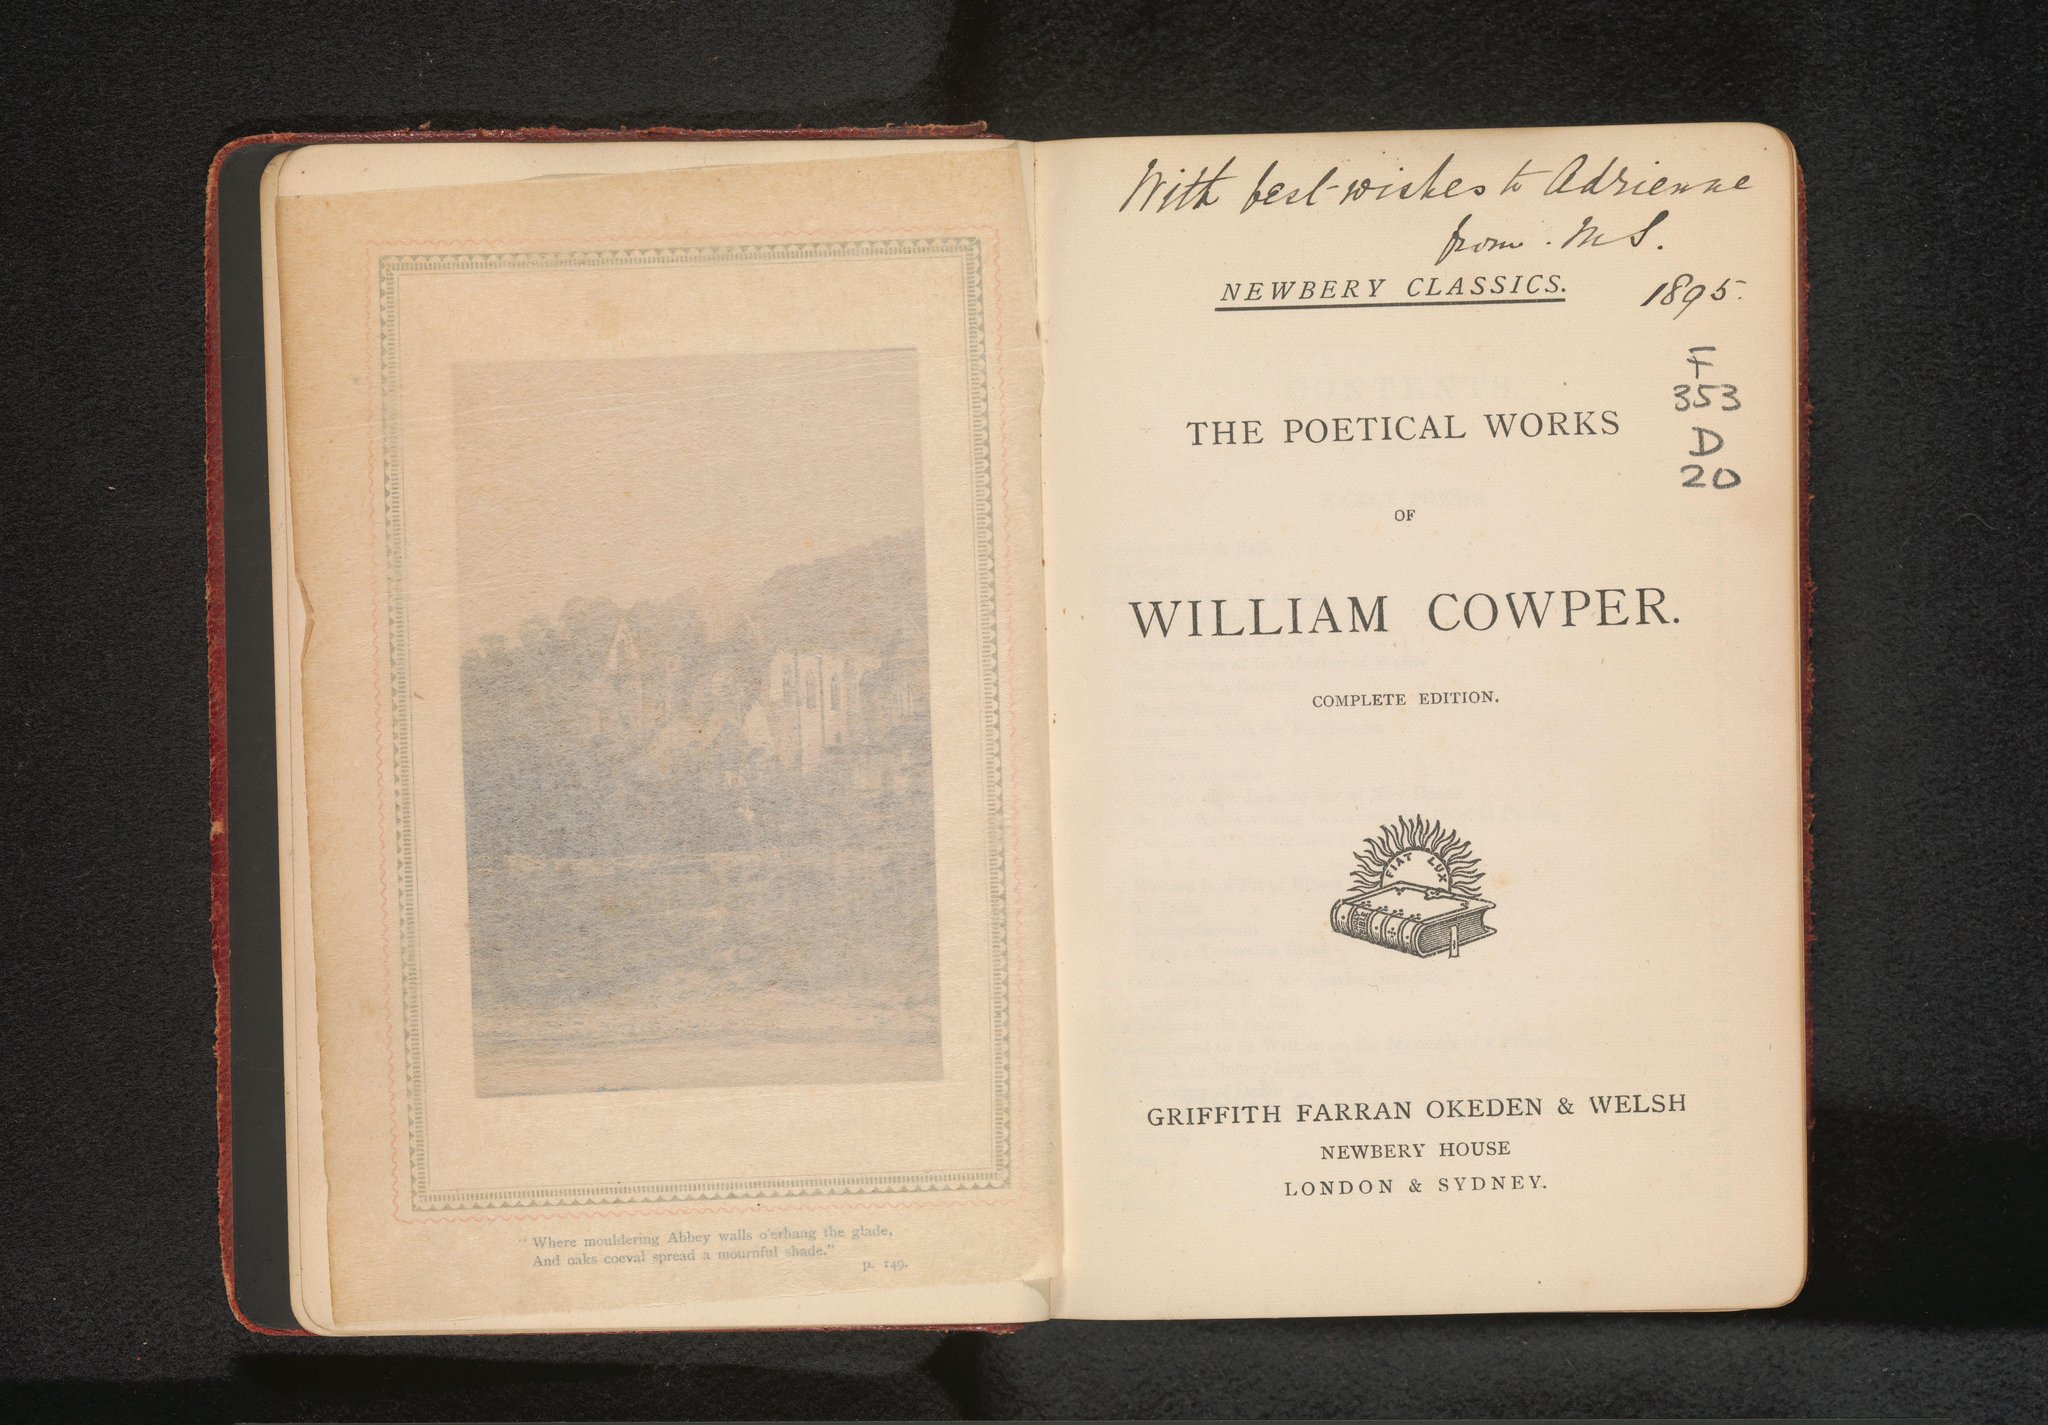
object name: book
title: The poetical works of William Cowper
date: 1890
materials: cardboard, leather, paper, photographic support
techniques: albumen print, printing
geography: london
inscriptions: dedication: ‘With best wishes to Adrienne/ from MS./ 1895.’, date: ‘OCT/ 1985’, annotation: ‘n[.]o s[.]’